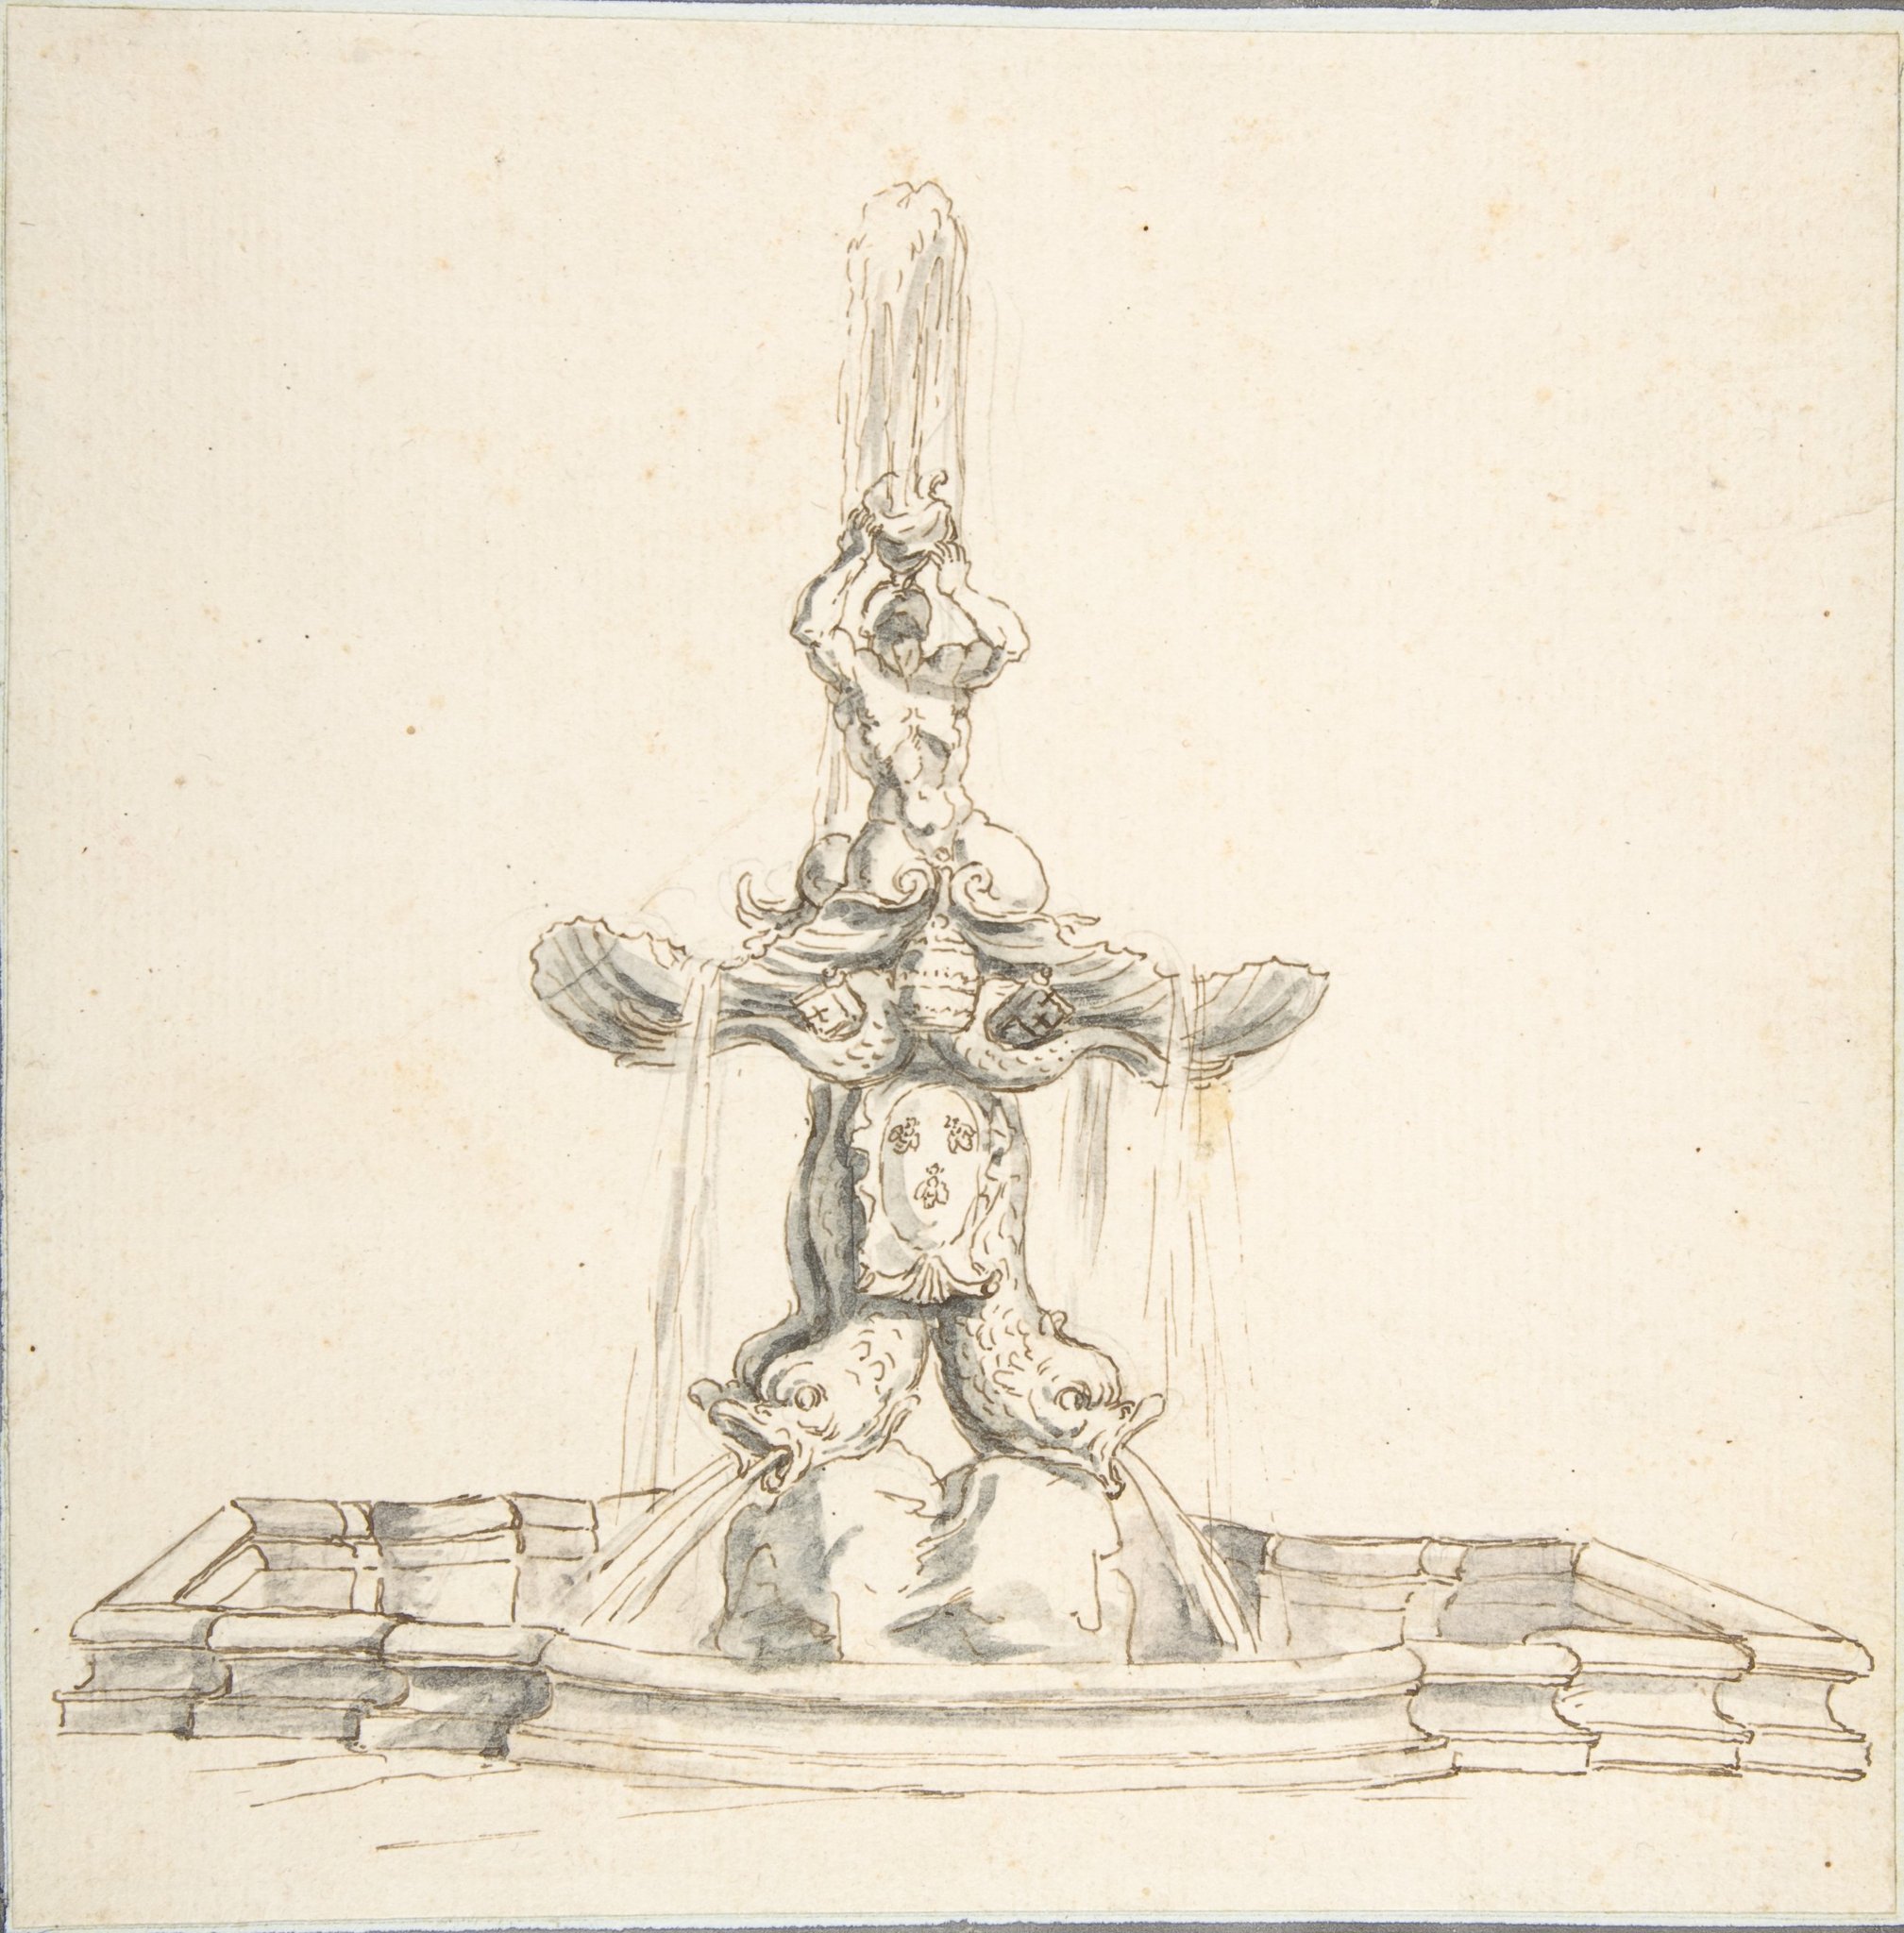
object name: drawing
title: Bernini's Fountain of "Il Tritone," Piazza Barberini, Rome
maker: anonymous, italian, 18th century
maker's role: artist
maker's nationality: italian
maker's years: 1700-1800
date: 1701-1800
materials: graphite, ink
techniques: brush, pen, wash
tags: human figures,fountains,fish